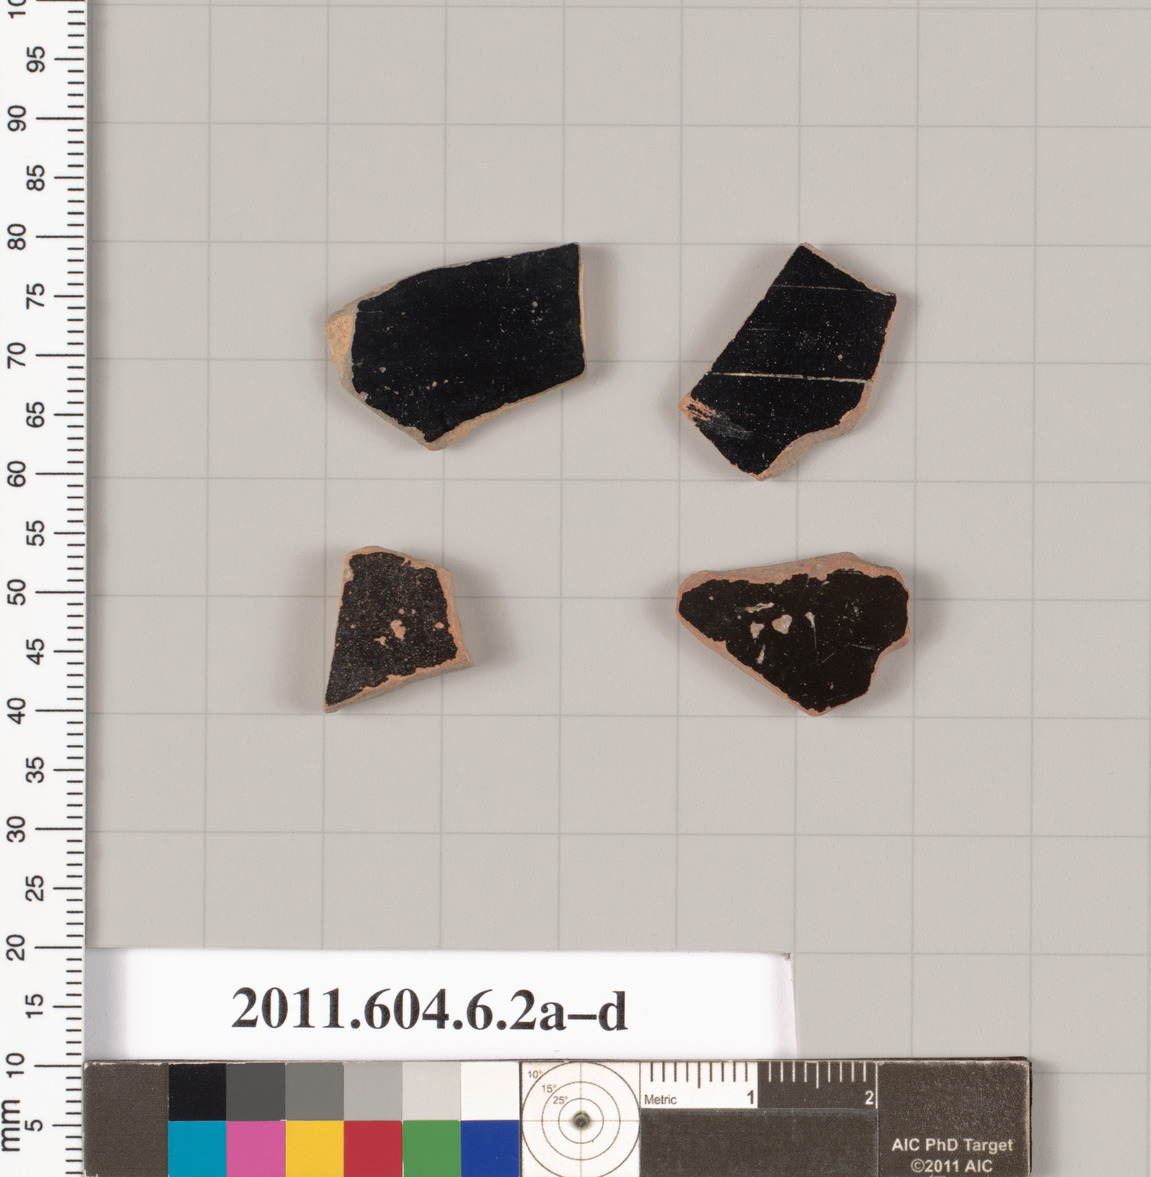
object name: undetermined open shape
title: Terracotta fragments of open shapes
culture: greek, attic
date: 600-401 BCE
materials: terracotta